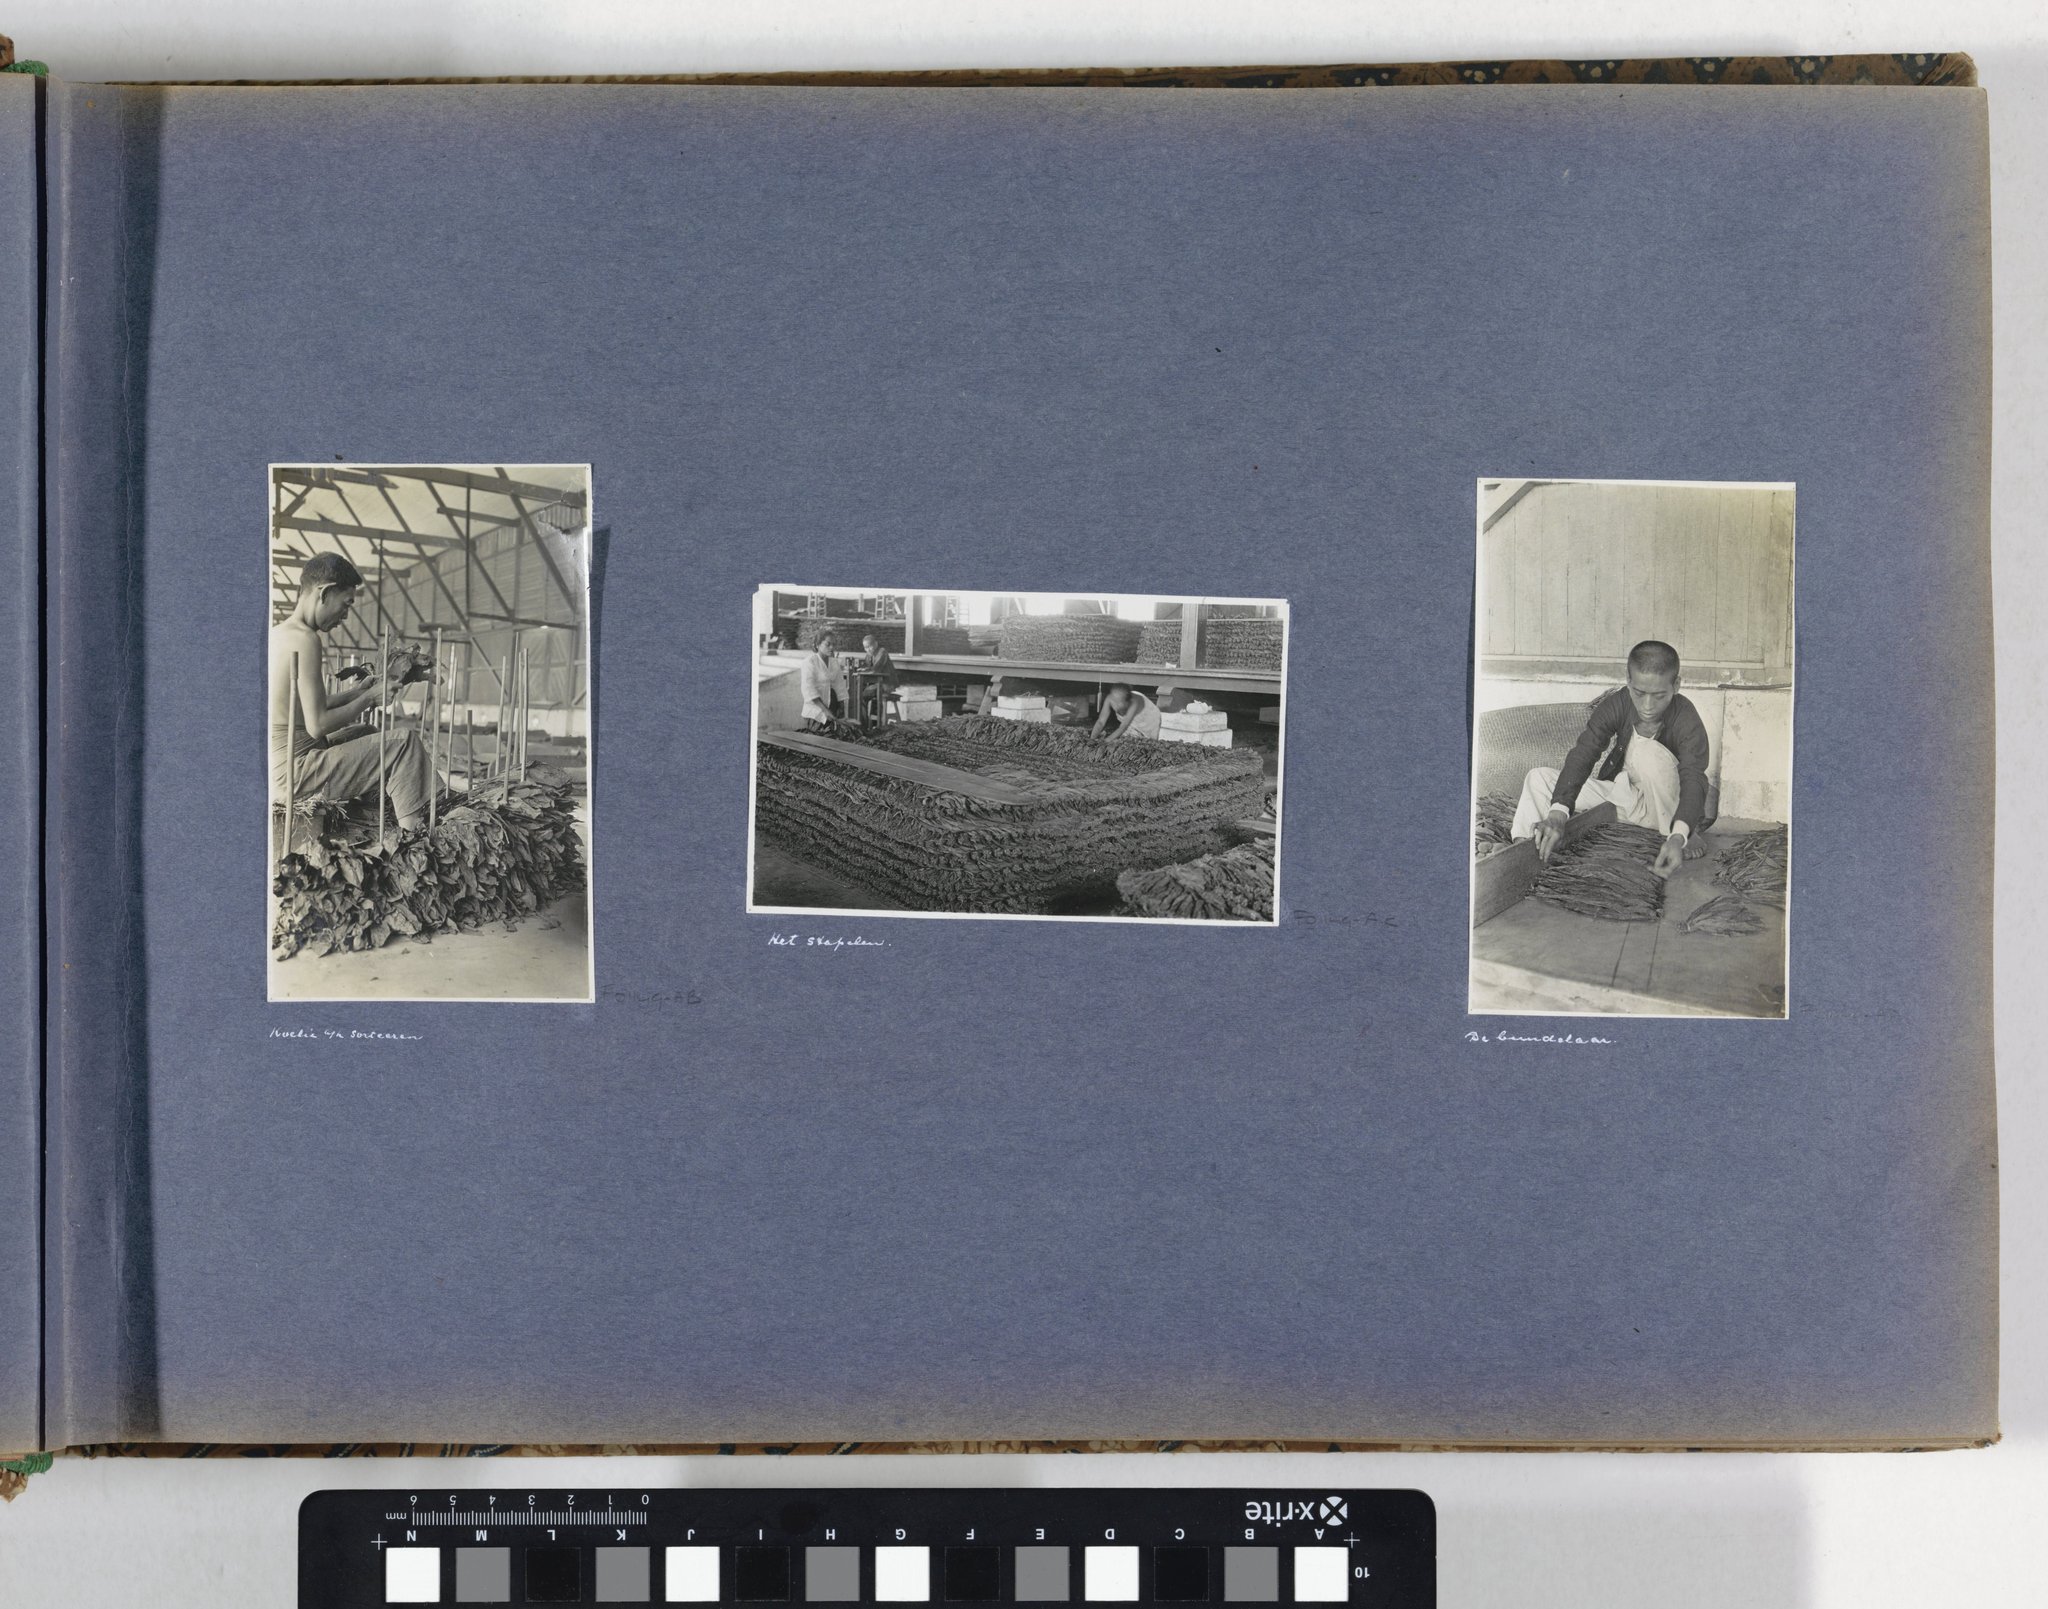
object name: album leaf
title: Koelie a/h sorteeren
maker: Anonymous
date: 1900-1920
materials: paper, photographic support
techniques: gelatin silver print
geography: sumatra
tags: plantation, working class, labourers, tobacco, sumatra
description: Onderdeel van reisalbum met foto's van bedrijvigheid en bezienswaardigheden op Sumatra en Java en van de reis naar en van Nederlands-Indië.